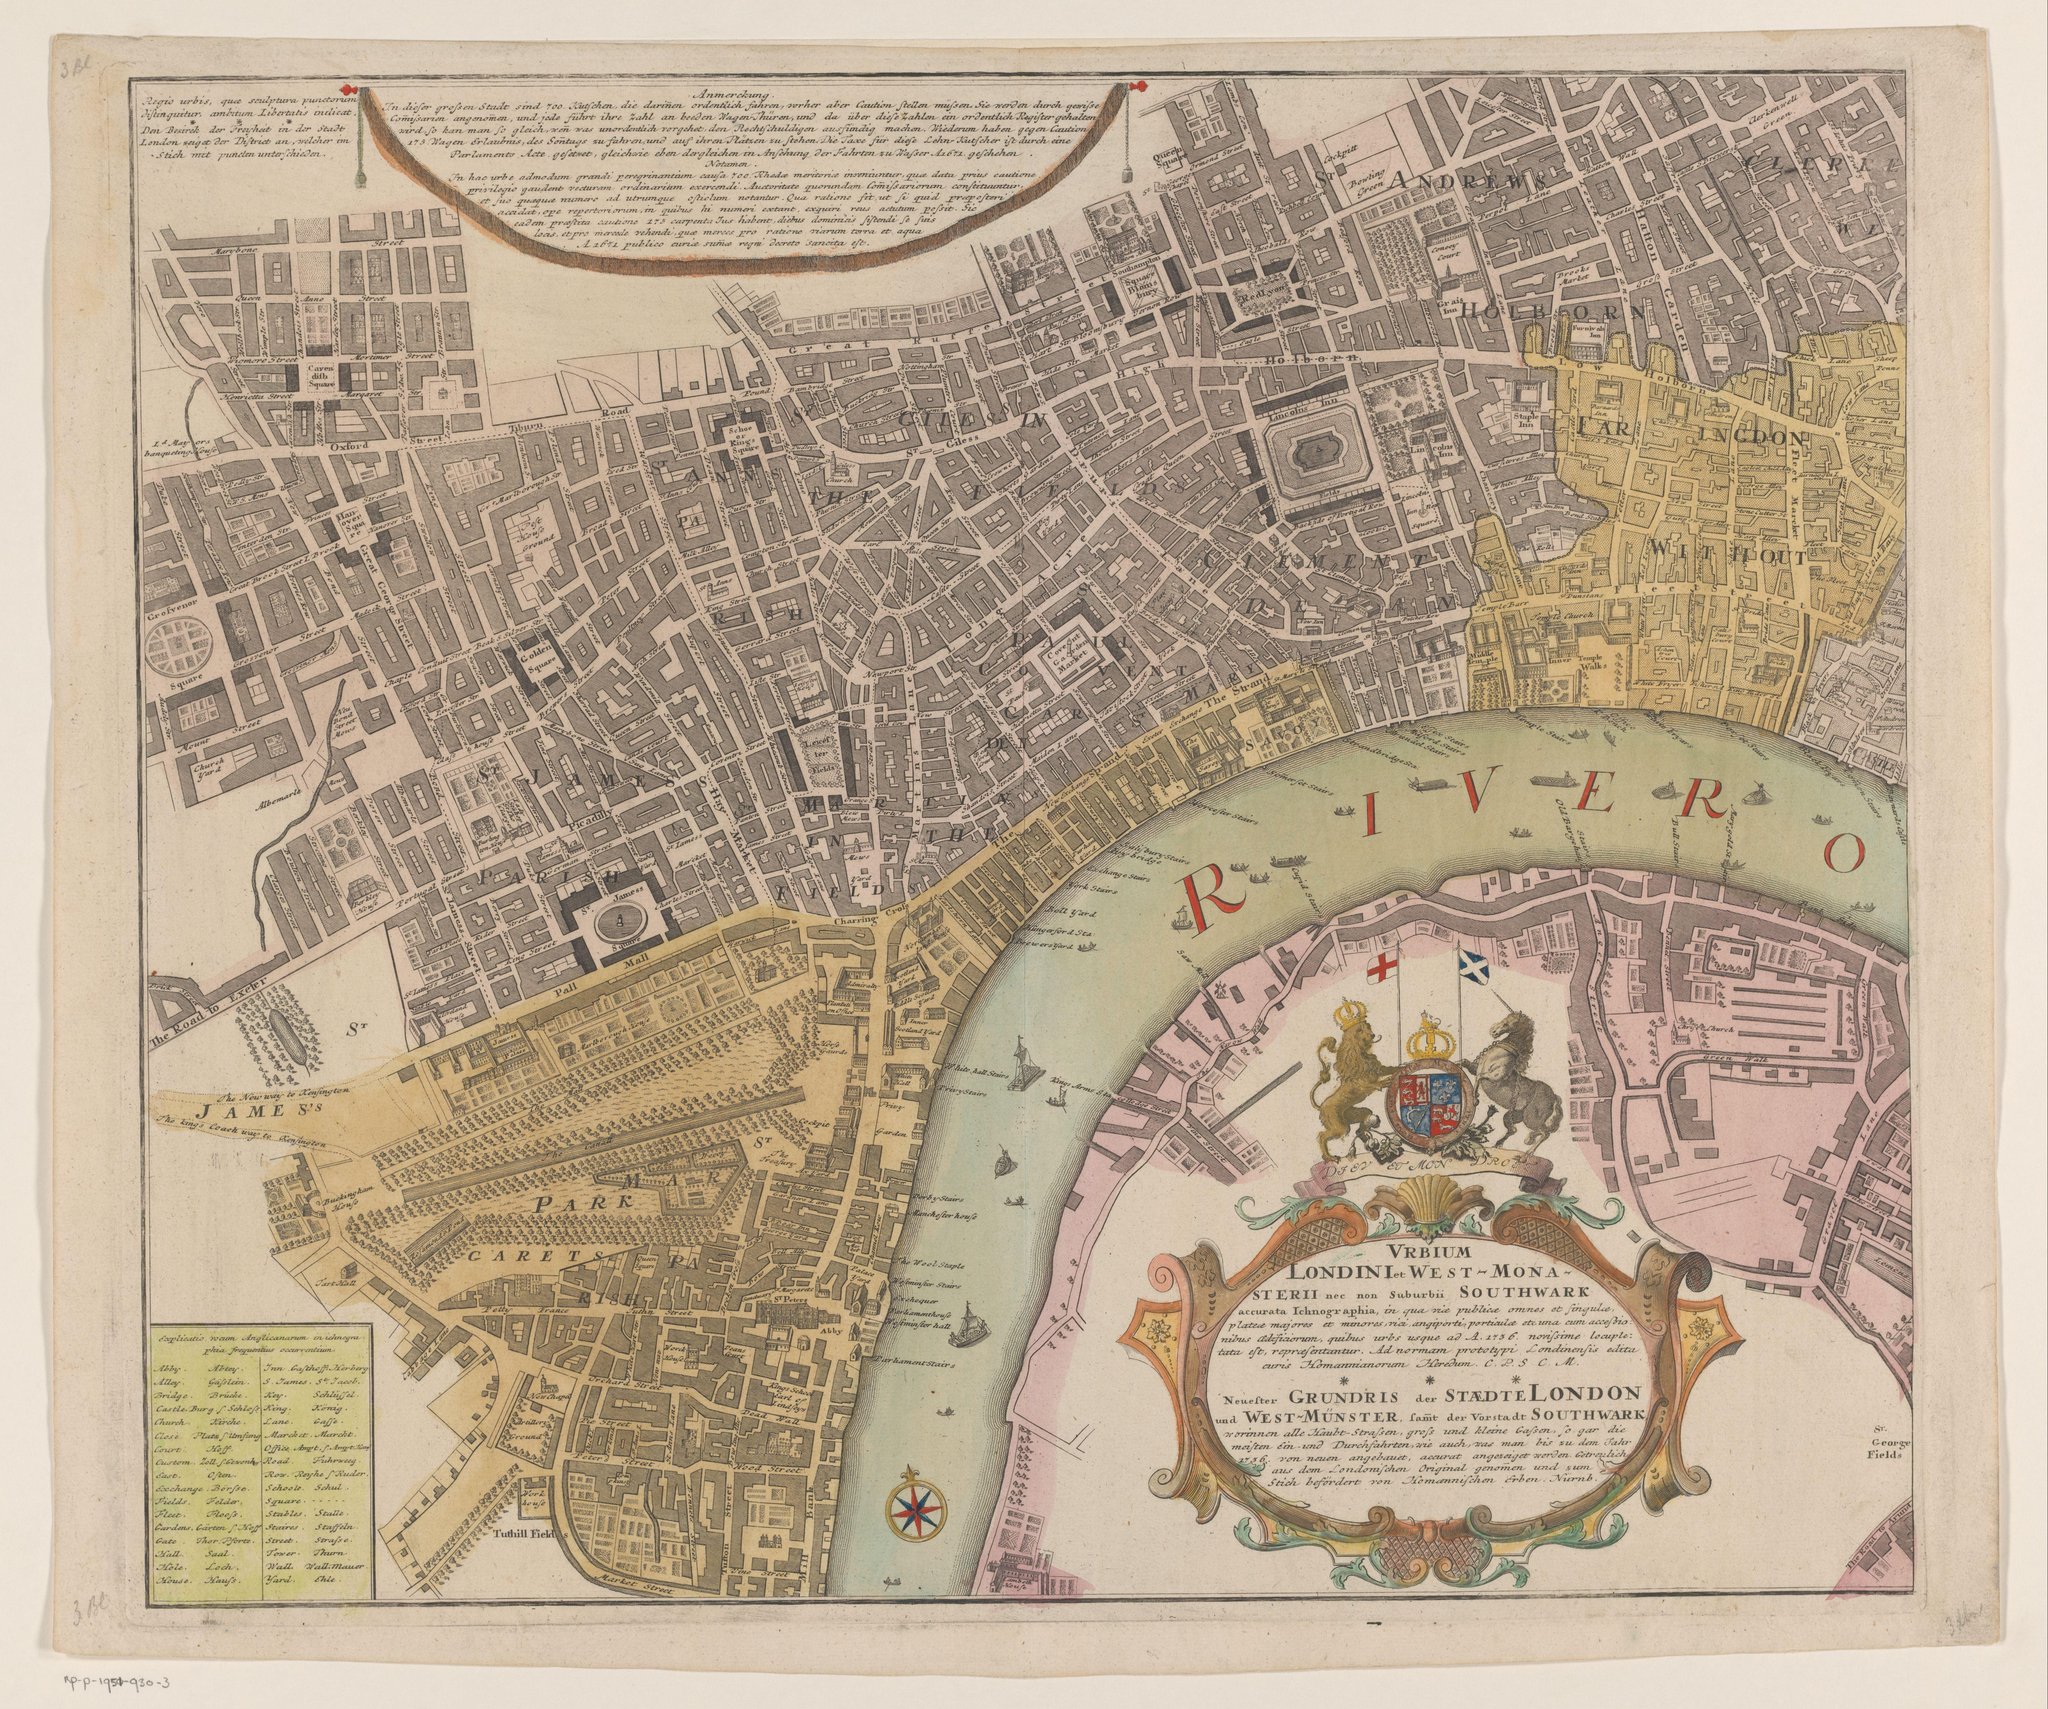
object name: area plan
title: Urbium Londini et west-Monasterii nec non suburbii Southwark (...) / Neuester grundris der staedte London und West-Münster, samt der vorstadt Southwark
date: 1736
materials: paper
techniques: engraving, etching, hand coloring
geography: nuremberg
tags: maps of cities, armorial bearing, heraldry, london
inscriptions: collector's mark: Lugt 2228